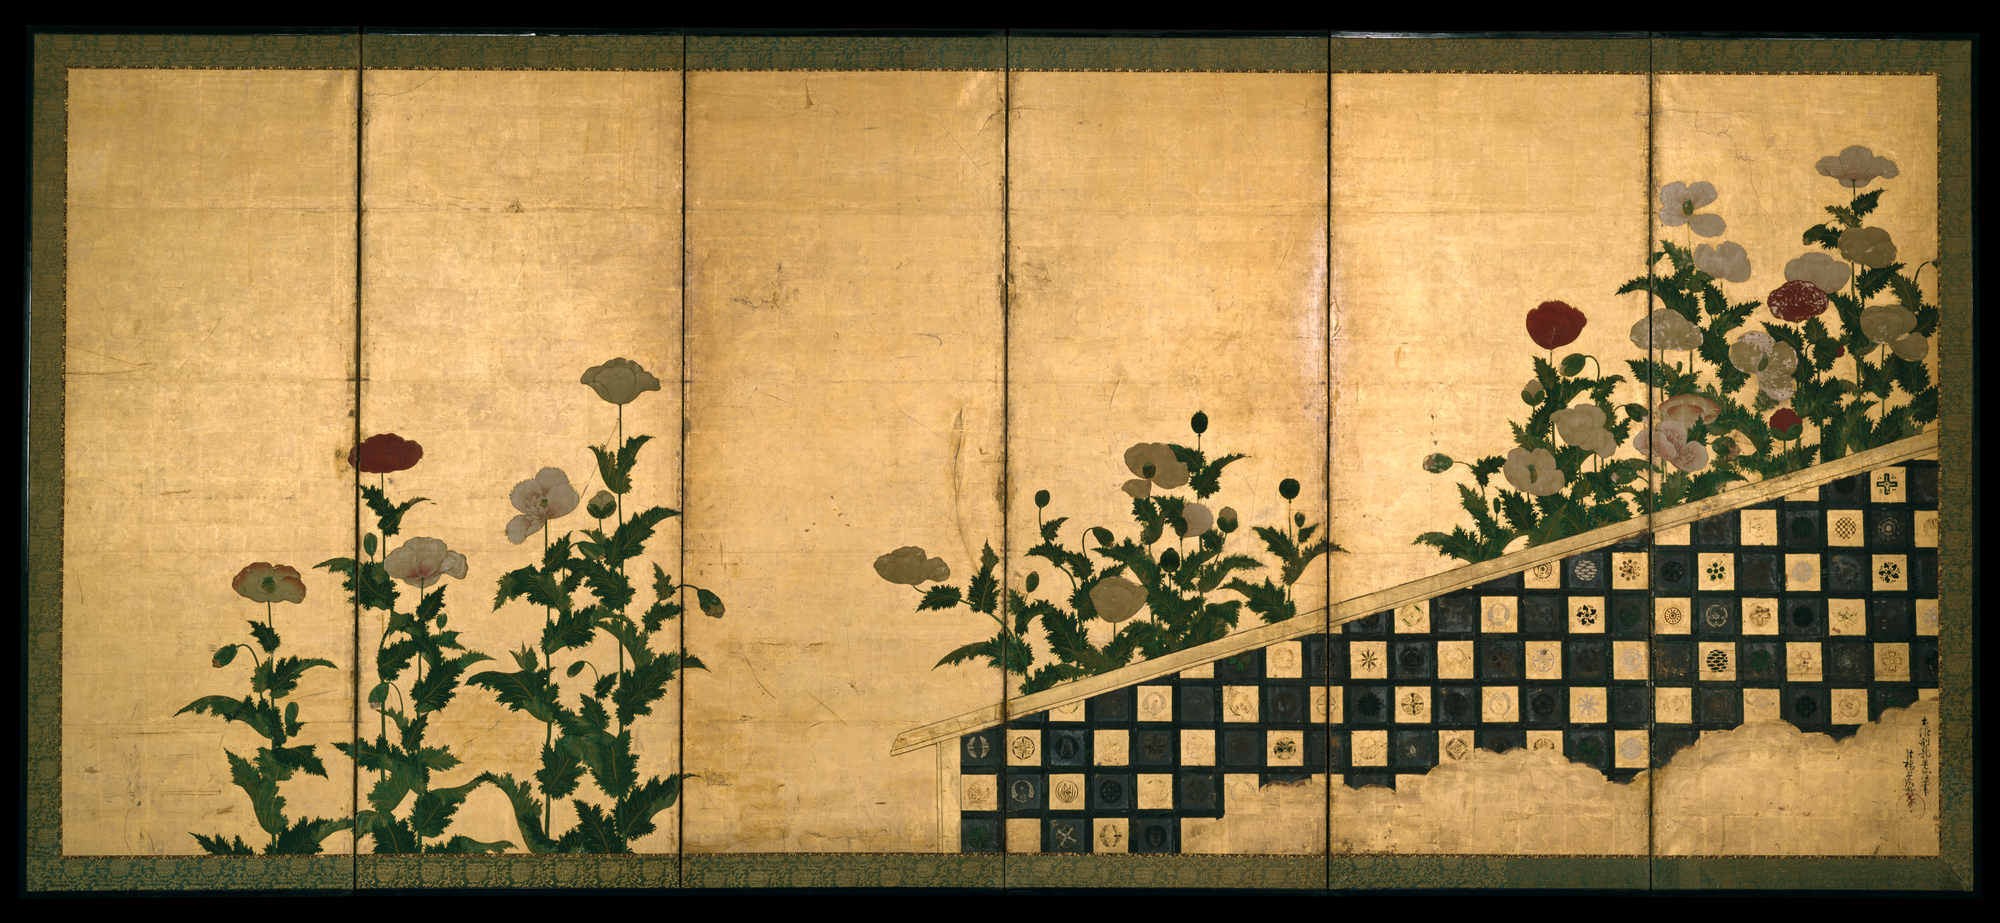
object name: screen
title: Red and White Poppies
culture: japanese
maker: tosa mitsumochi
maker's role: artist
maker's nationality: japanese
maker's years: 1525-1559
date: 1601-1633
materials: gold leaf, ink, panel, paper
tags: poppies